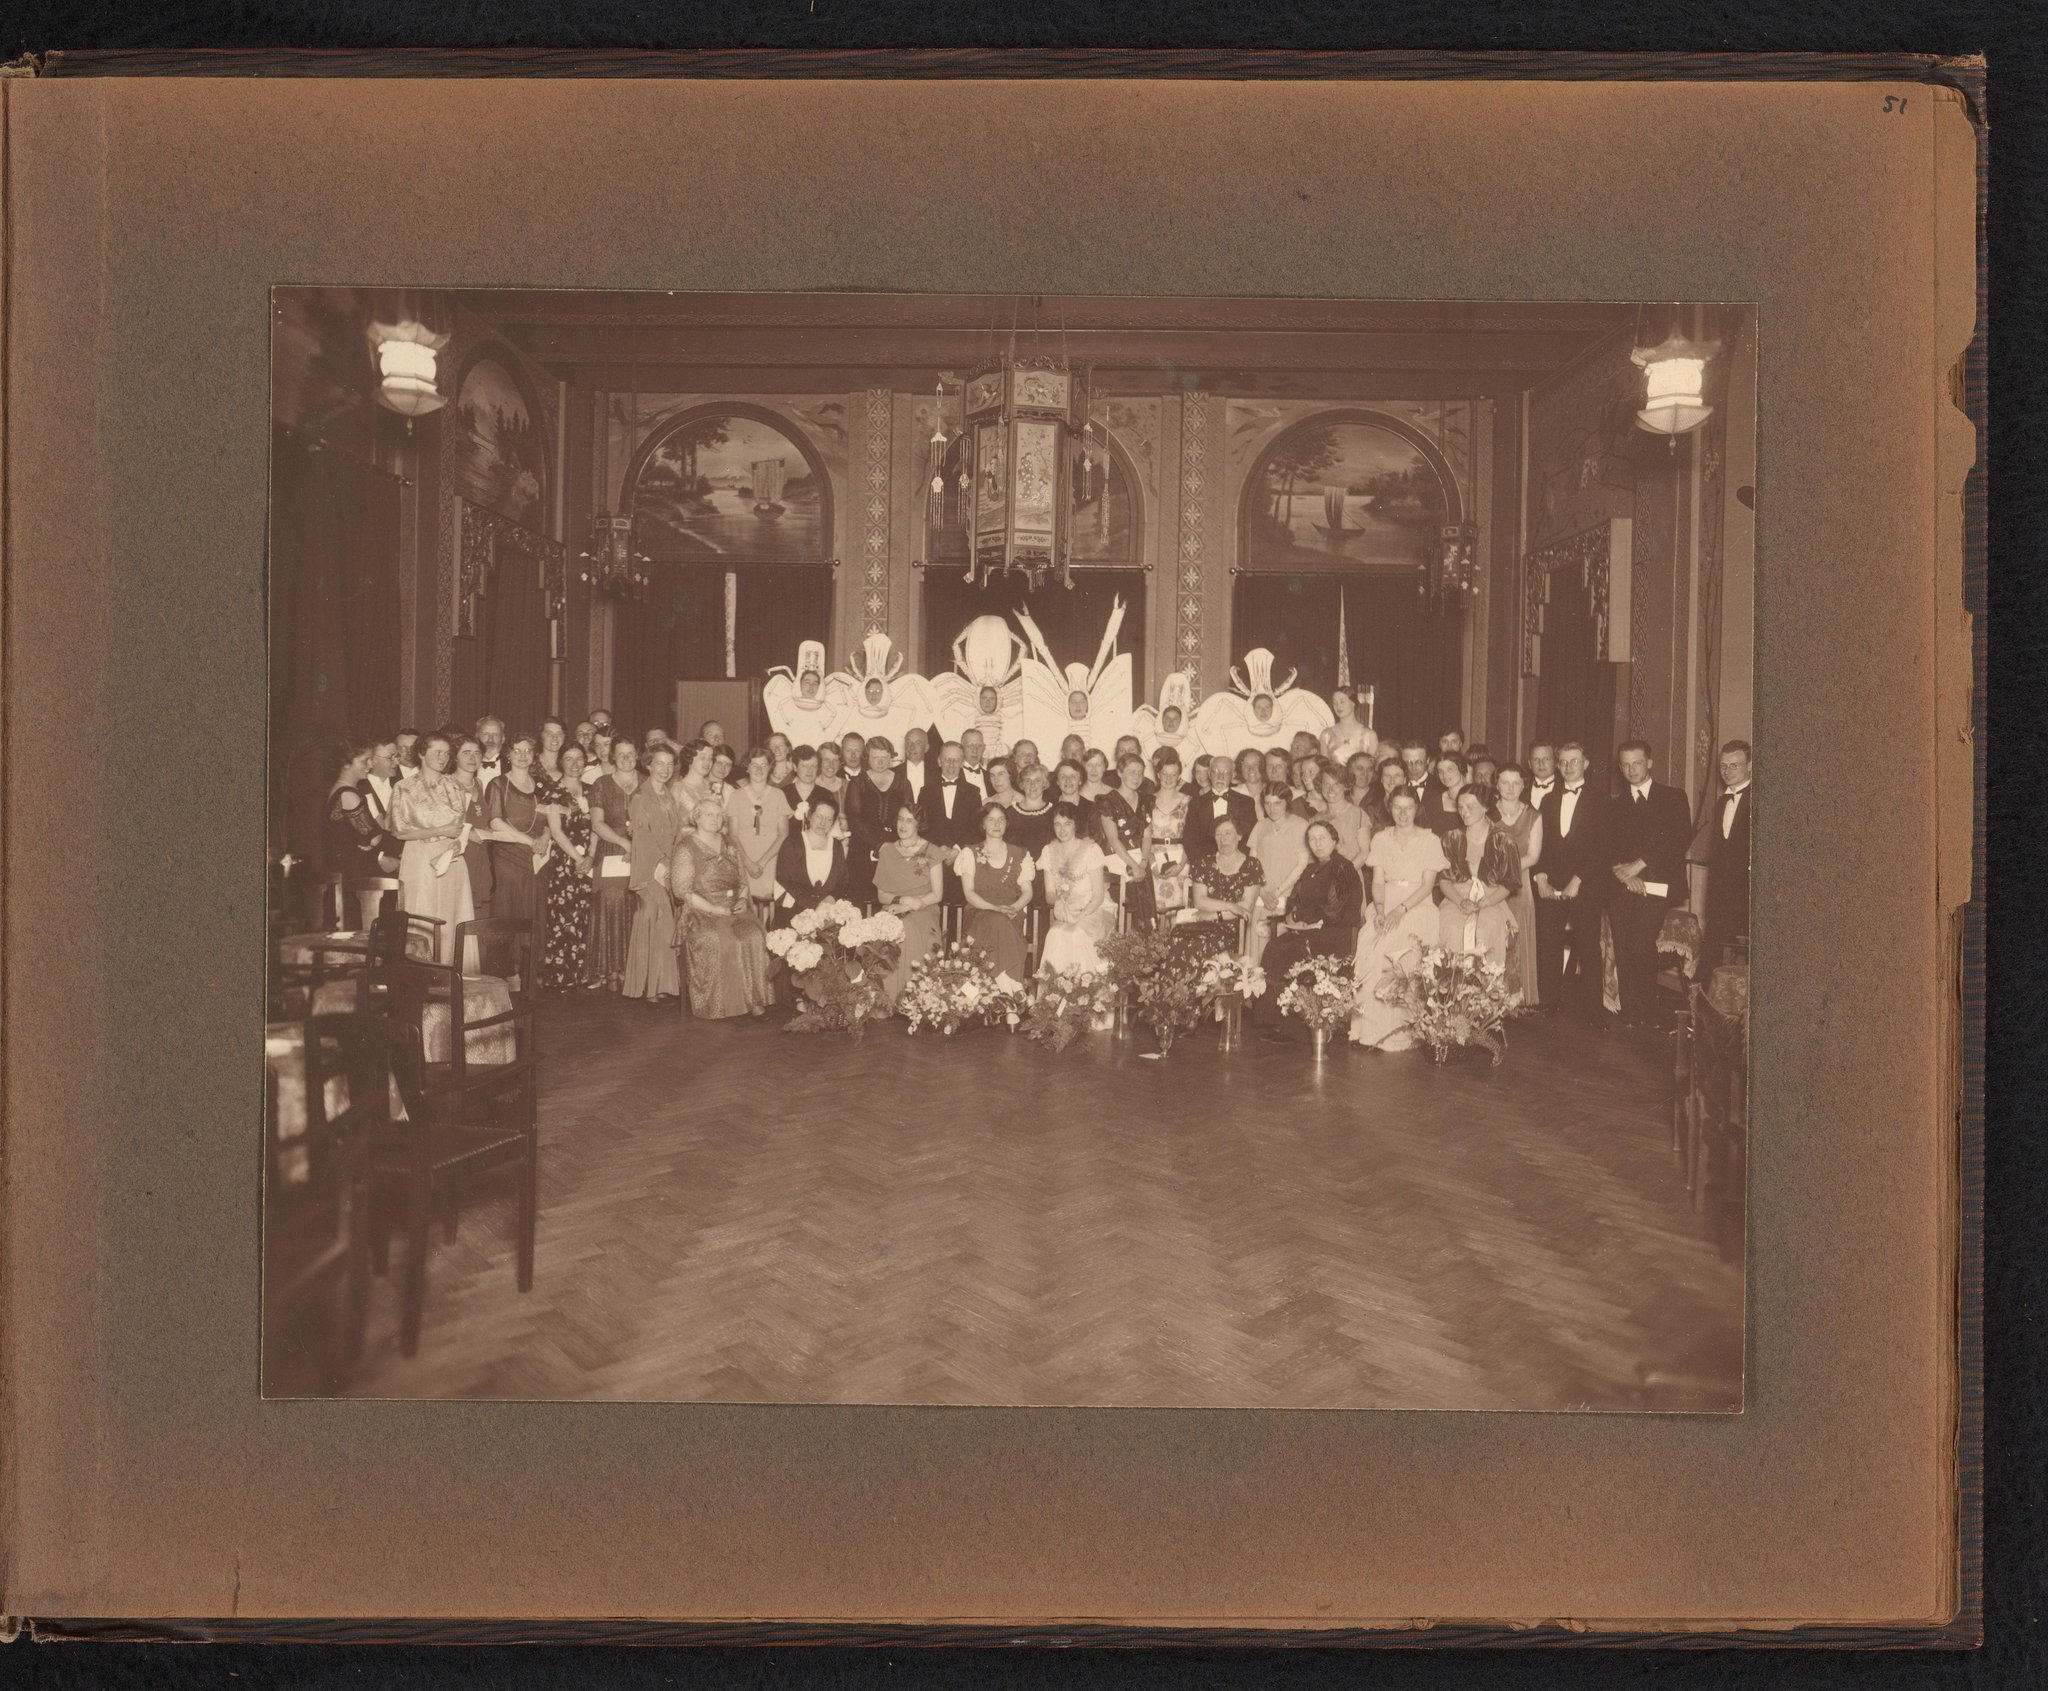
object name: album leaf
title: Bladzijde uit het fotoalbum van de familie Diepenbrock met 1 groepsfoto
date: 1909-1920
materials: cardboard, photographic support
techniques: photography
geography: amsterdam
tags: netherlands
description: Bruin albumblad 51 van familiealbum van Alphons Diepenbrock.